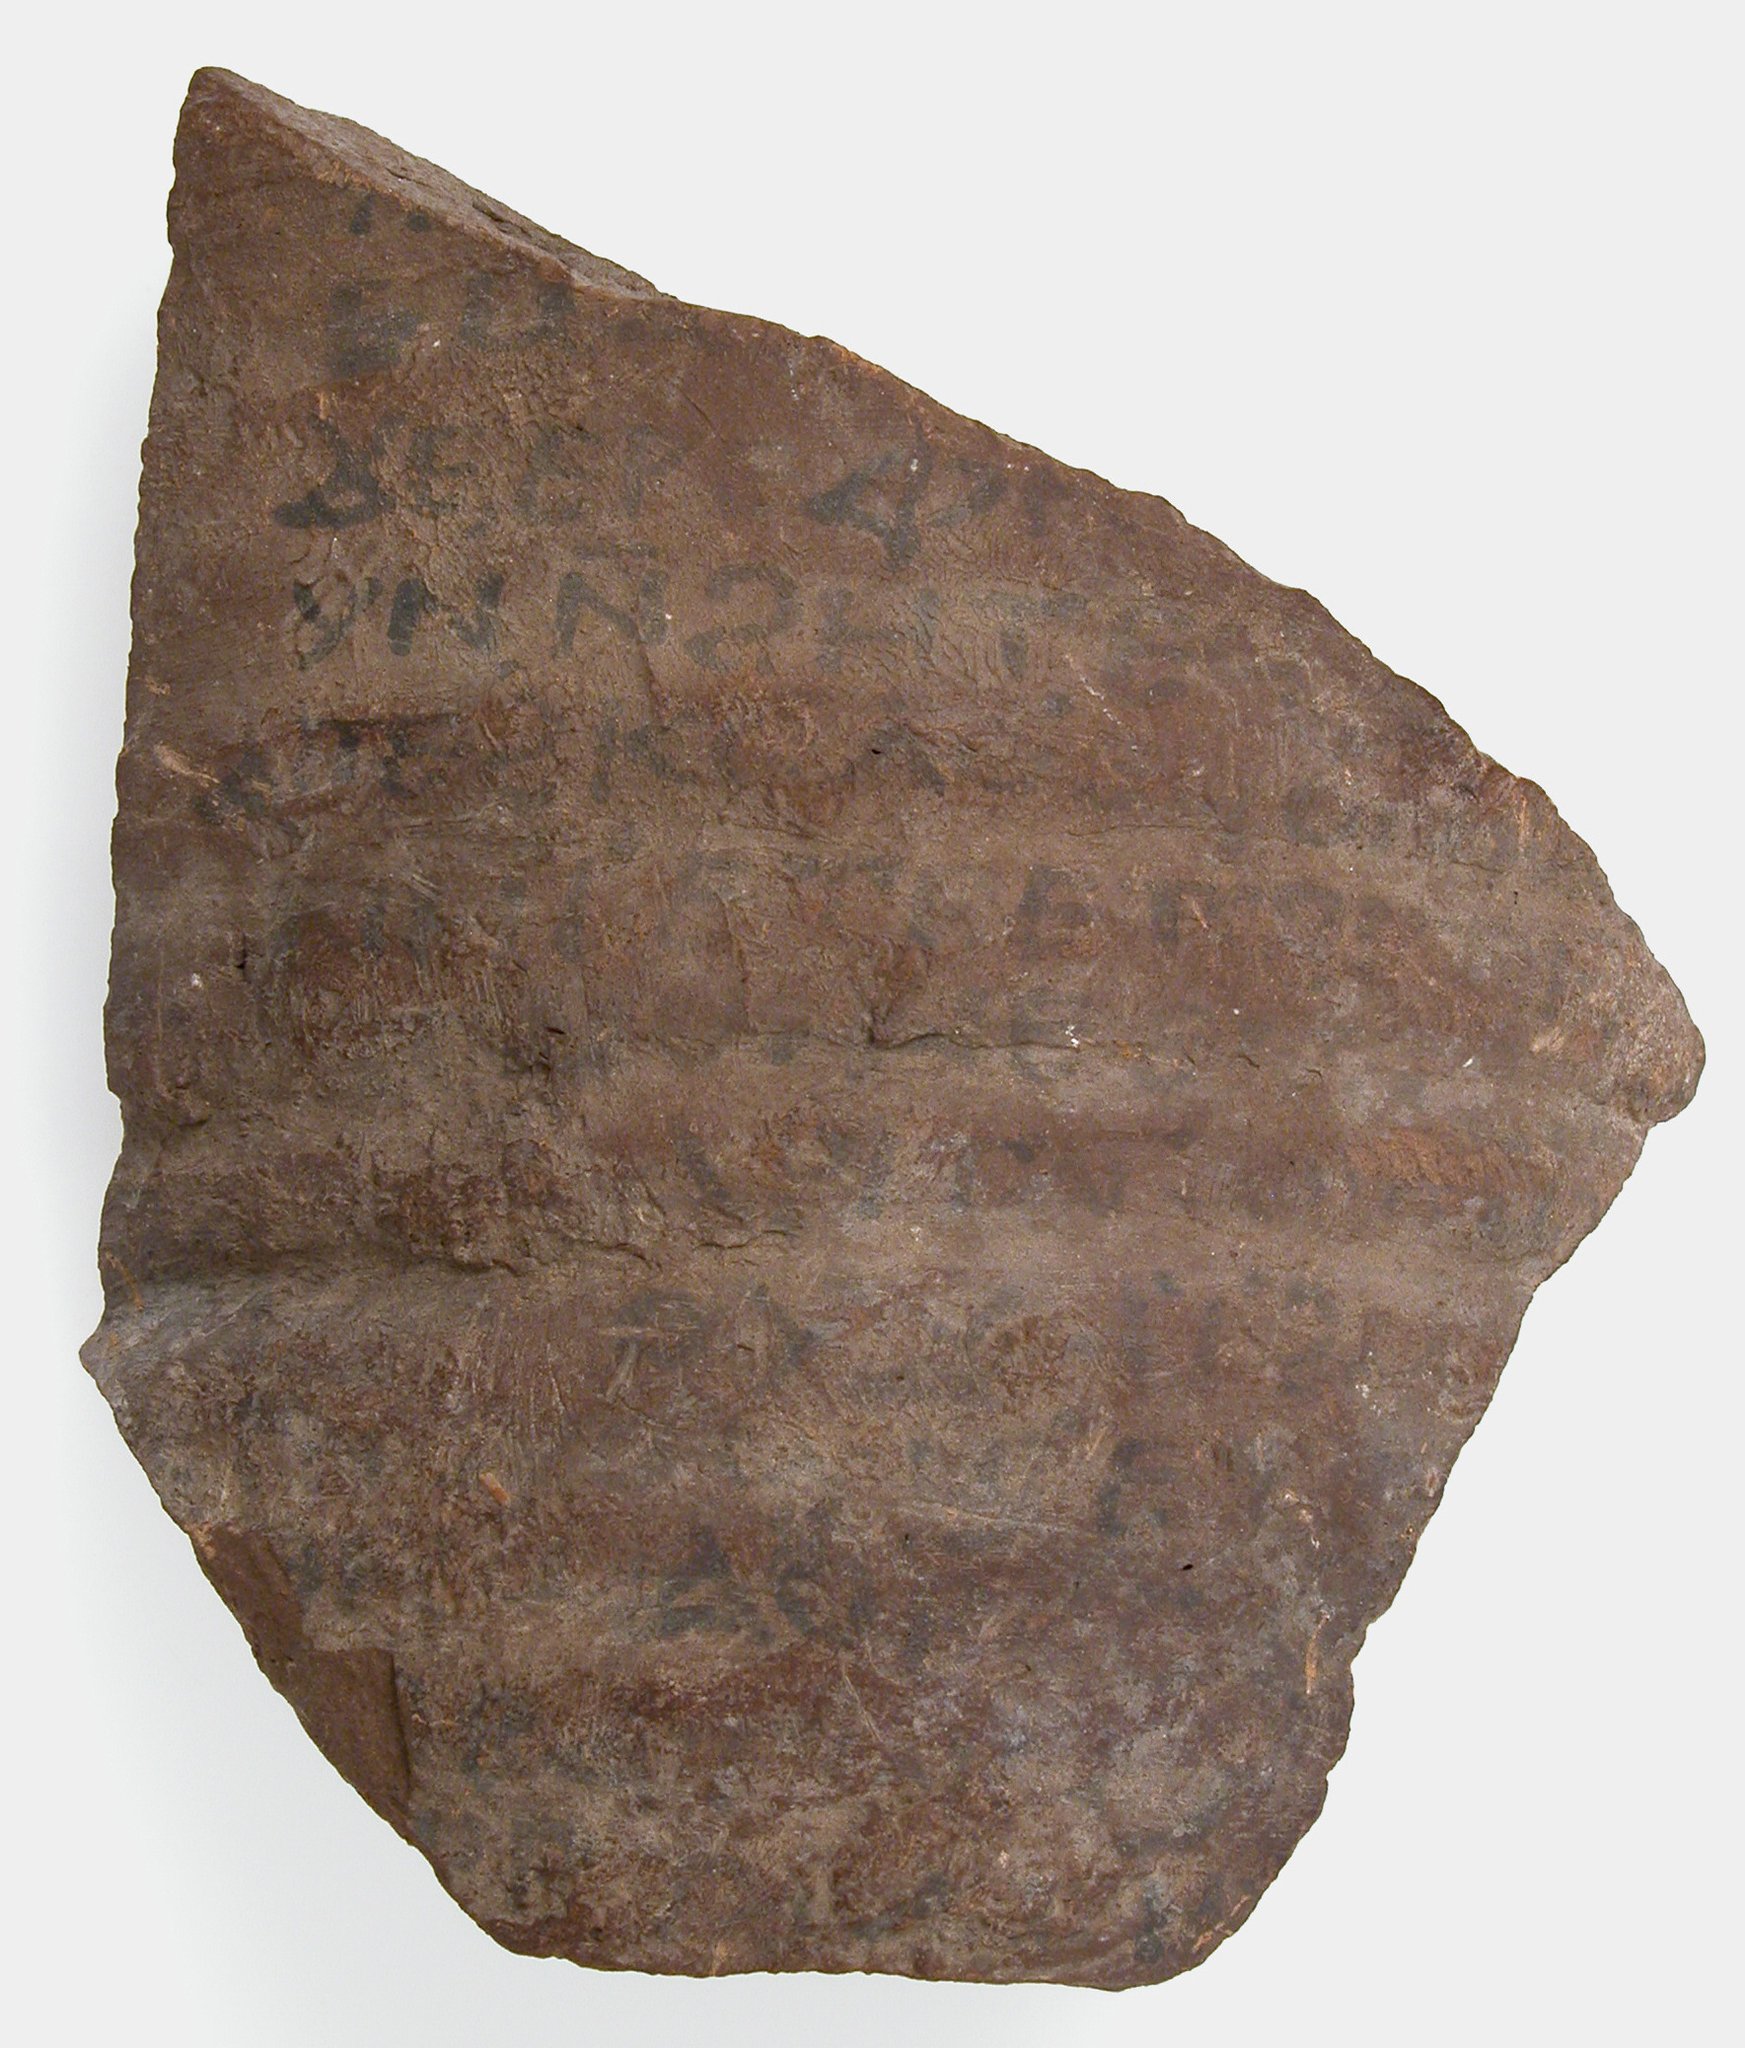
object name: ostrakon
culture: coptic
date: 601-700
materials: ink, pottery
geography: egypt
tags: coptic